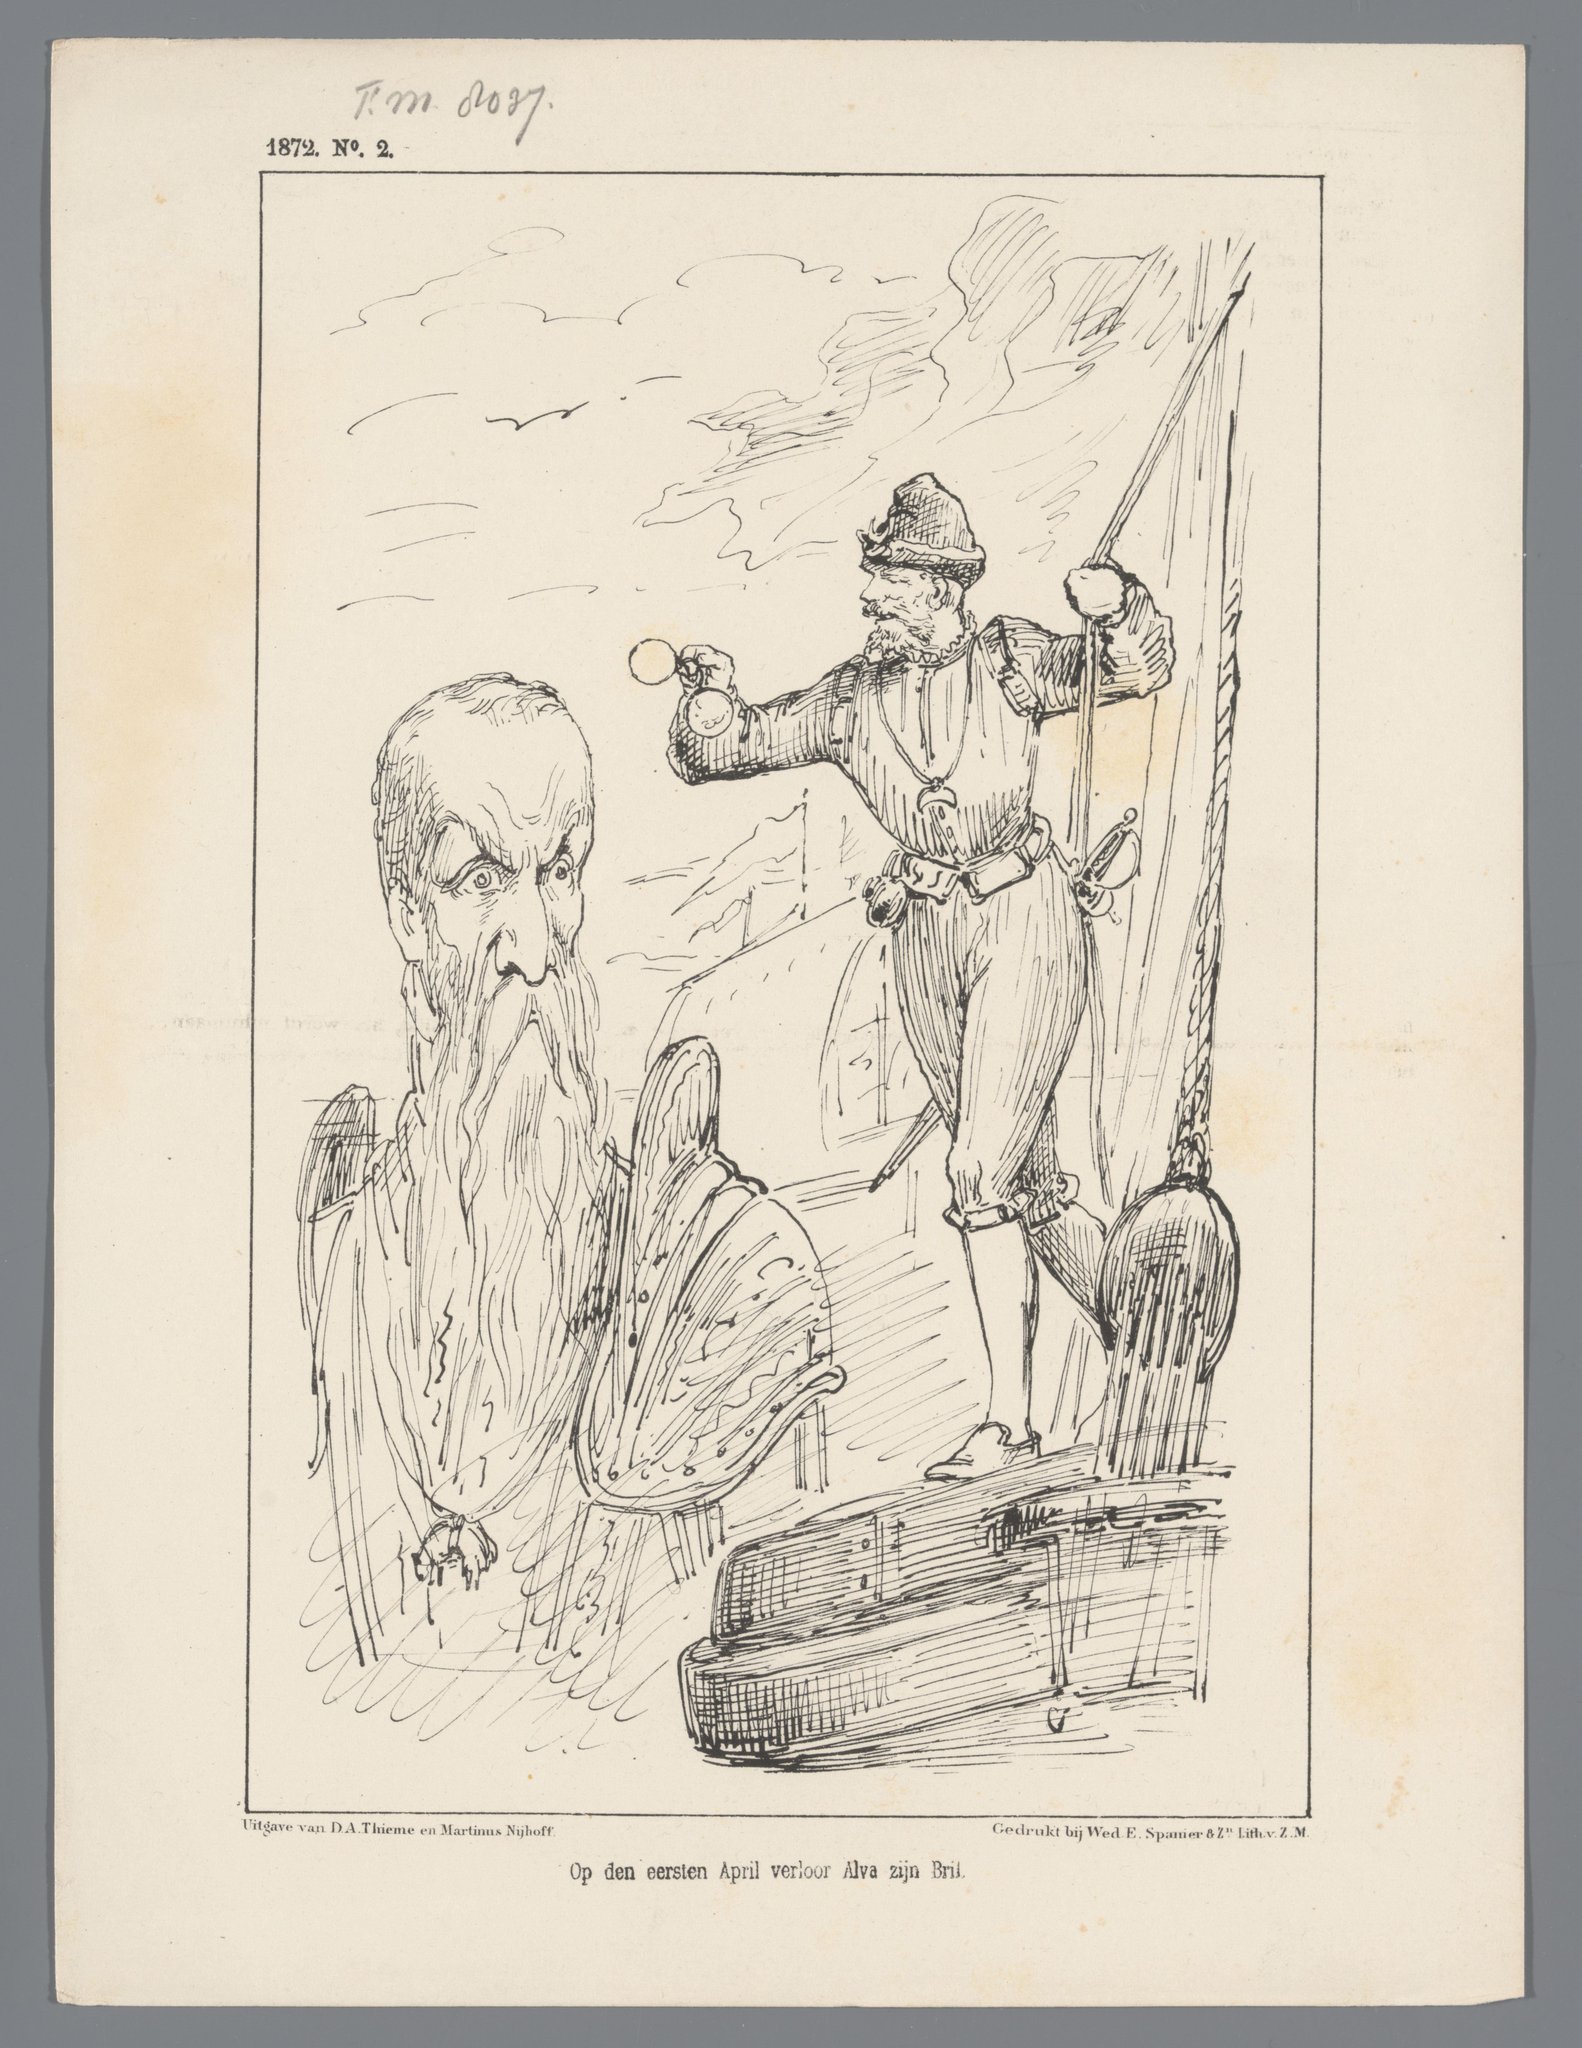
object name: cartoon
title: Op den eersten April verloor Alva zijn Bril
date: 1872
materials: paper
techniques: lithograph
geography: netherlands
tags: fernando álvarez de toledo (3rd duke of alba), brielle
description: Spotprent nav de aanstaande viering van de driehonderdste gedenkdag van de iname van Den Briel op 1 april 1572-1872. De hertog van Alva kijkt boos naar een watergeus met zijn bril. Plaat verschenen bij het weekblad De Nederlandsche Spectator, nr. 2, 1872.